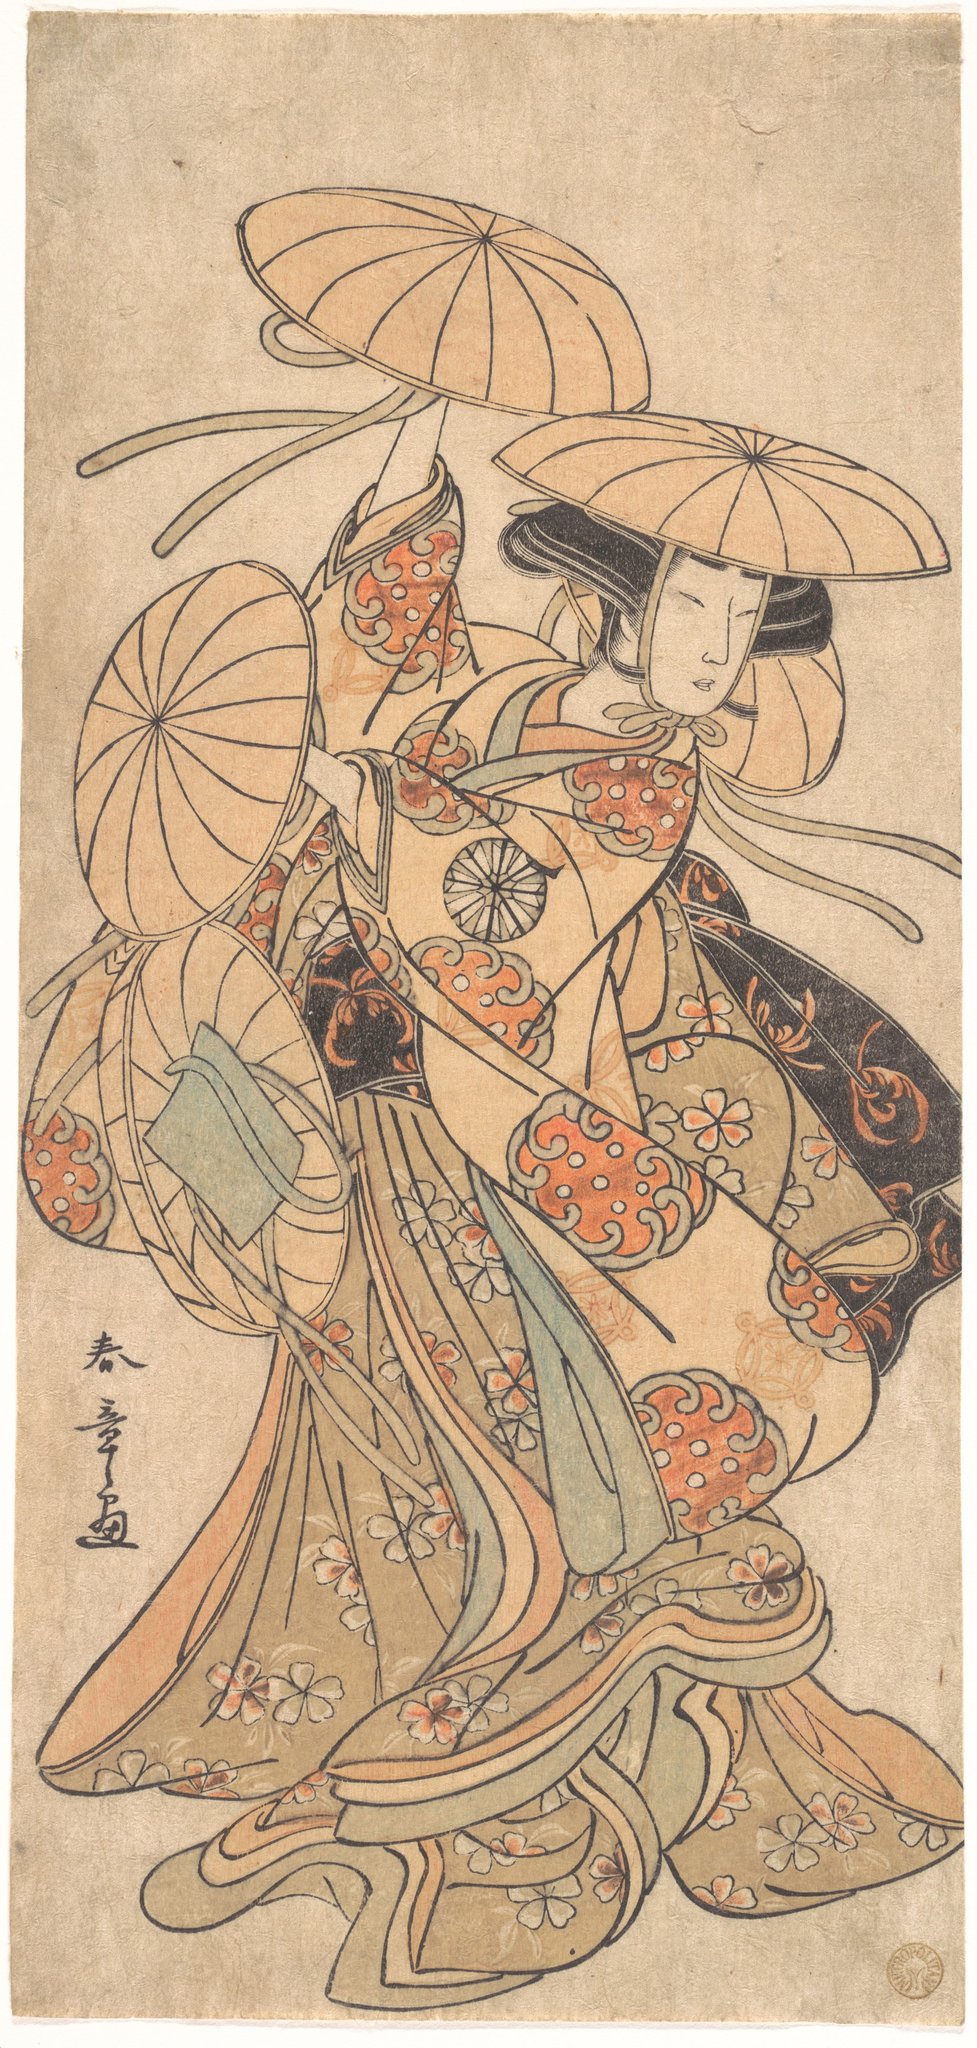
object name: woodblock print nishiki e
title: Kabuki Actor Nakamura Tomijūrō I in a Female Dance Role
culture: japanese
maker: katsukawa shunshō 勝川春章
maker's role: artist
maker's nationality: japanese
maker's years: 1726-1792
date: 1777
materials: ink, paper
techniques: nishiki e, woodblock print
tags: dance,actors